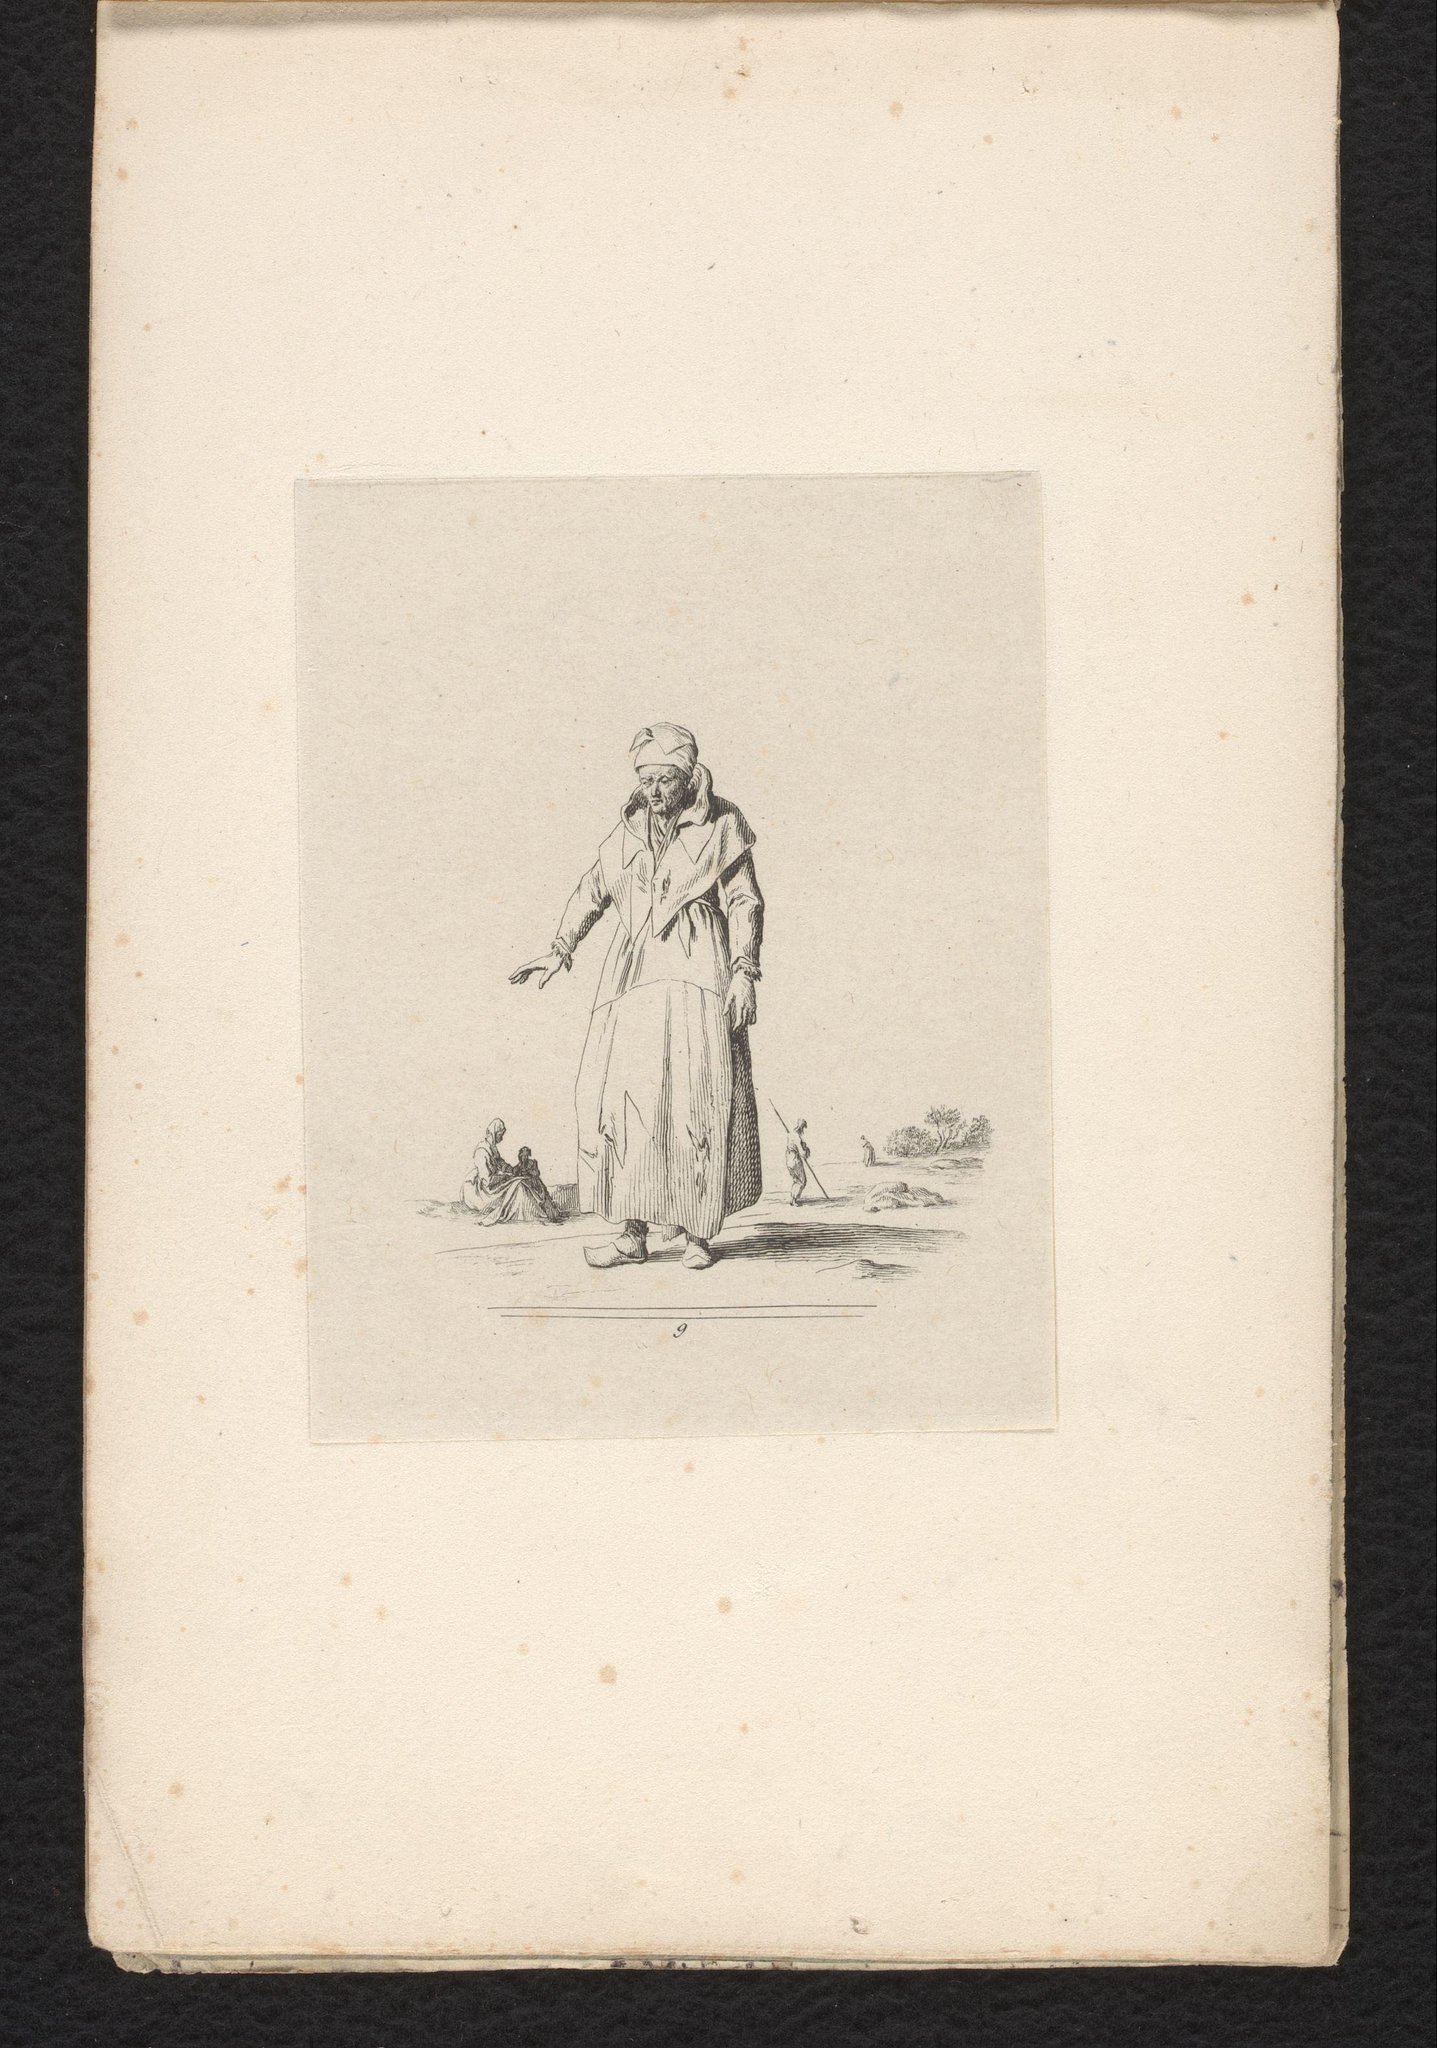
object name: print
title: Oude bedelares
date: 1798-1806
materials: paper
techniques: engraving, etching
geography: paris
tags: clothed in rags, beggar